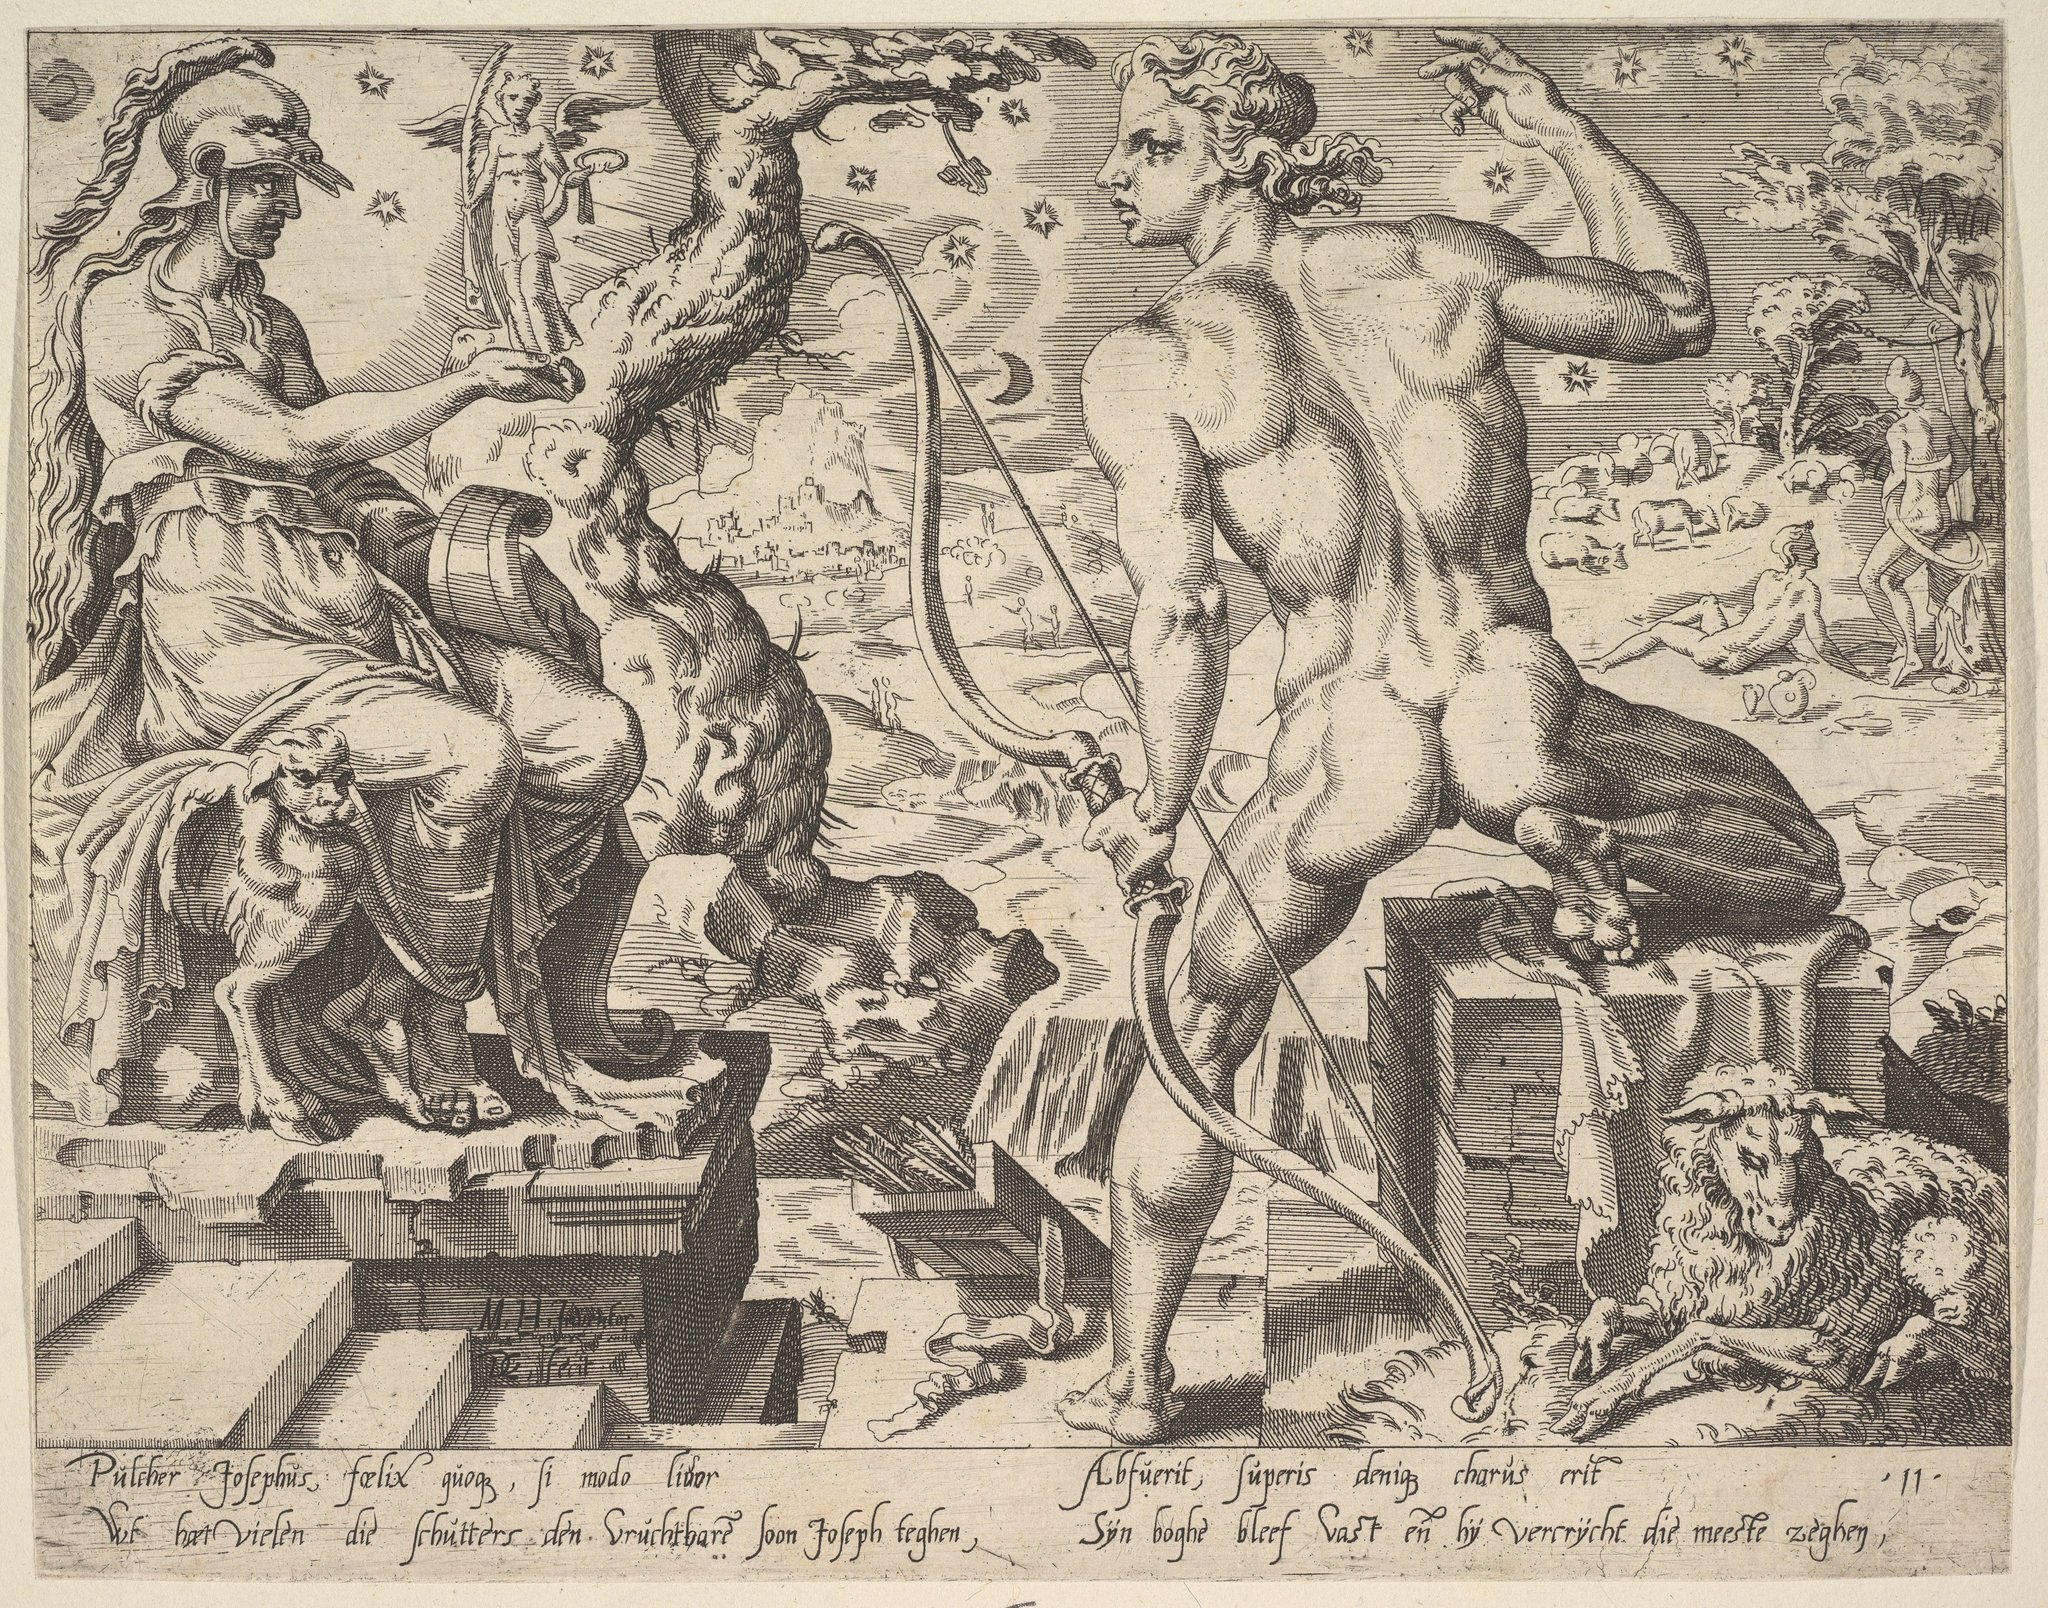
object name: print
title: Joseph, from "The Twelve Patriarchs"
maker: maarten van heemskerck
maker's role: artist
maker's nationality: netherlandish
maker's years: 1498-1574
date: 1550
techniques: etching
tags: bow and arrow,male nudes,sheep